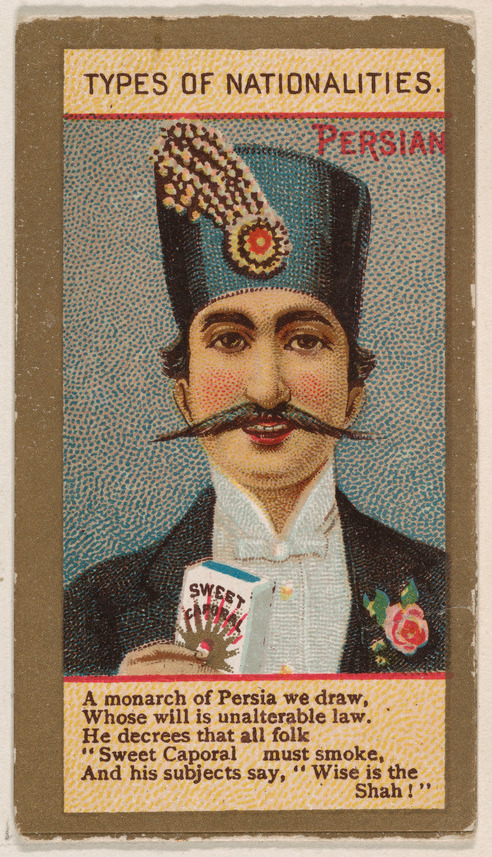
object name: print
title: Persian, from Types of Nationalities (N240) issued by Kinney Bros.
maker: kinney brothers tobacco company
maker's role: publisher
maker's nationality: american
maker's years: 1869-2011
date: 1890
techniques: color lithograph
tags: men